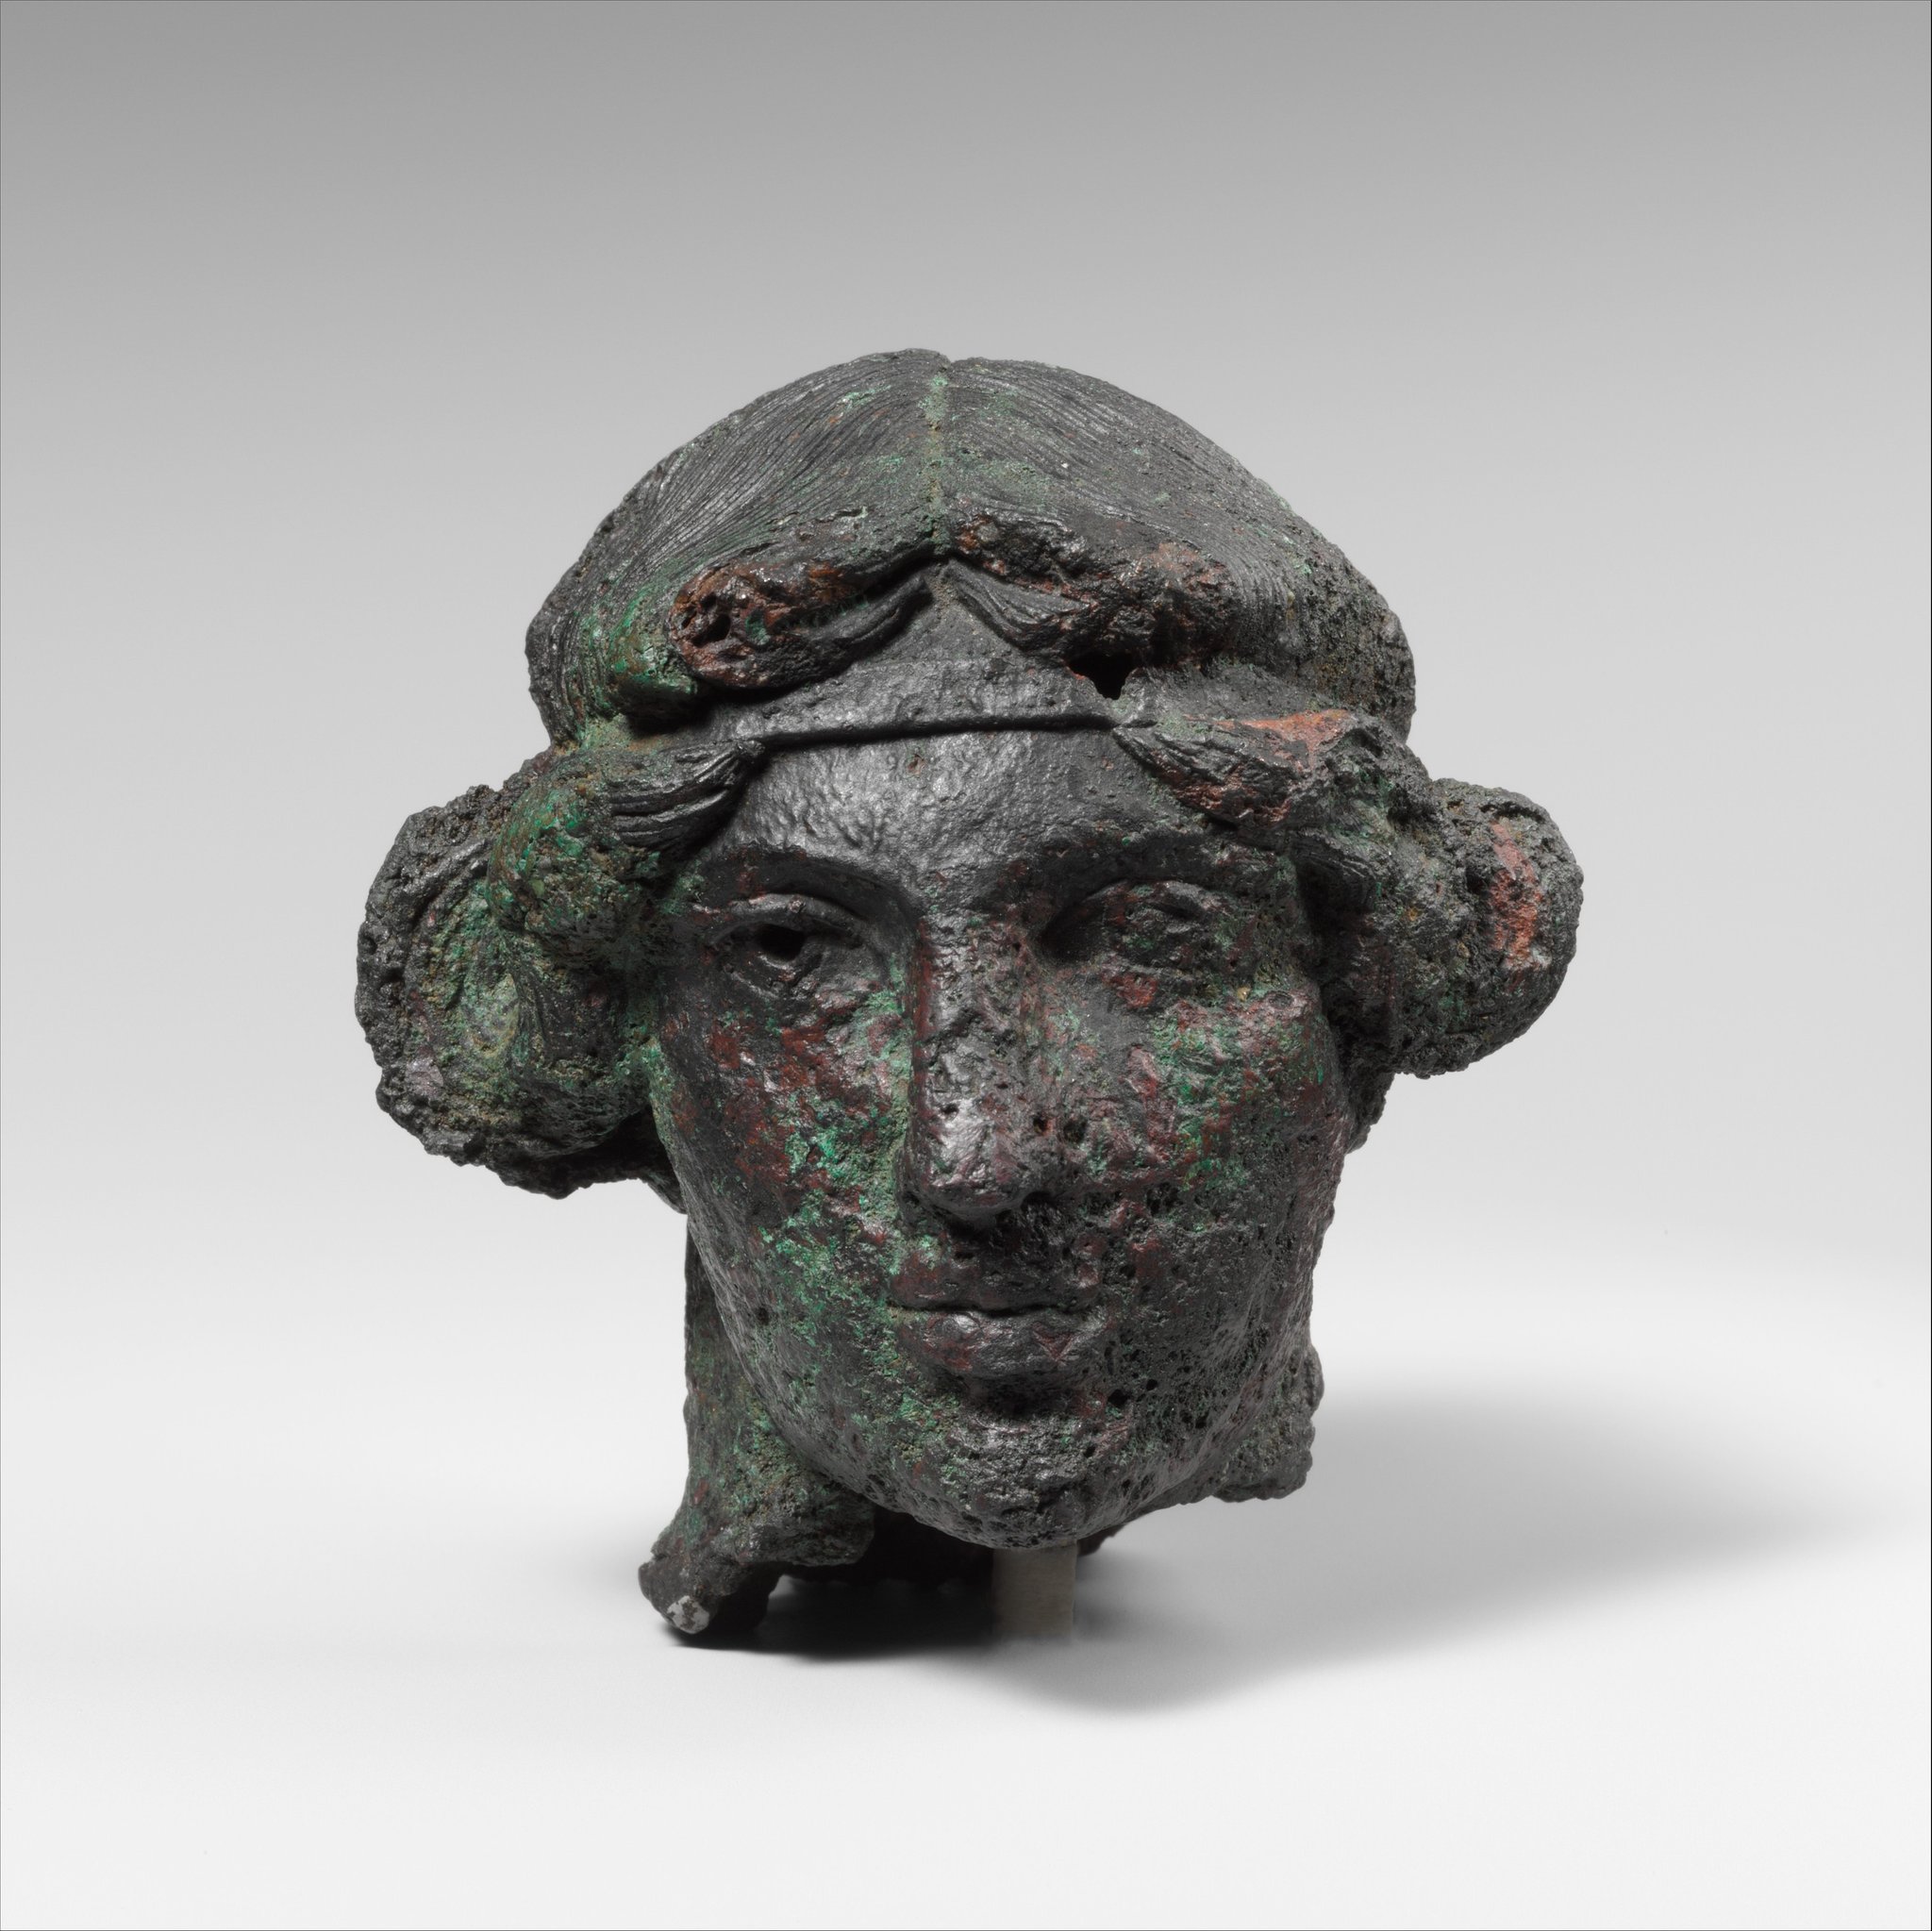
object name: head of a youth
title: Bronze head of a youth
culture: greek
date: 450-426 BCE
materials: bronze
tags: heads,men